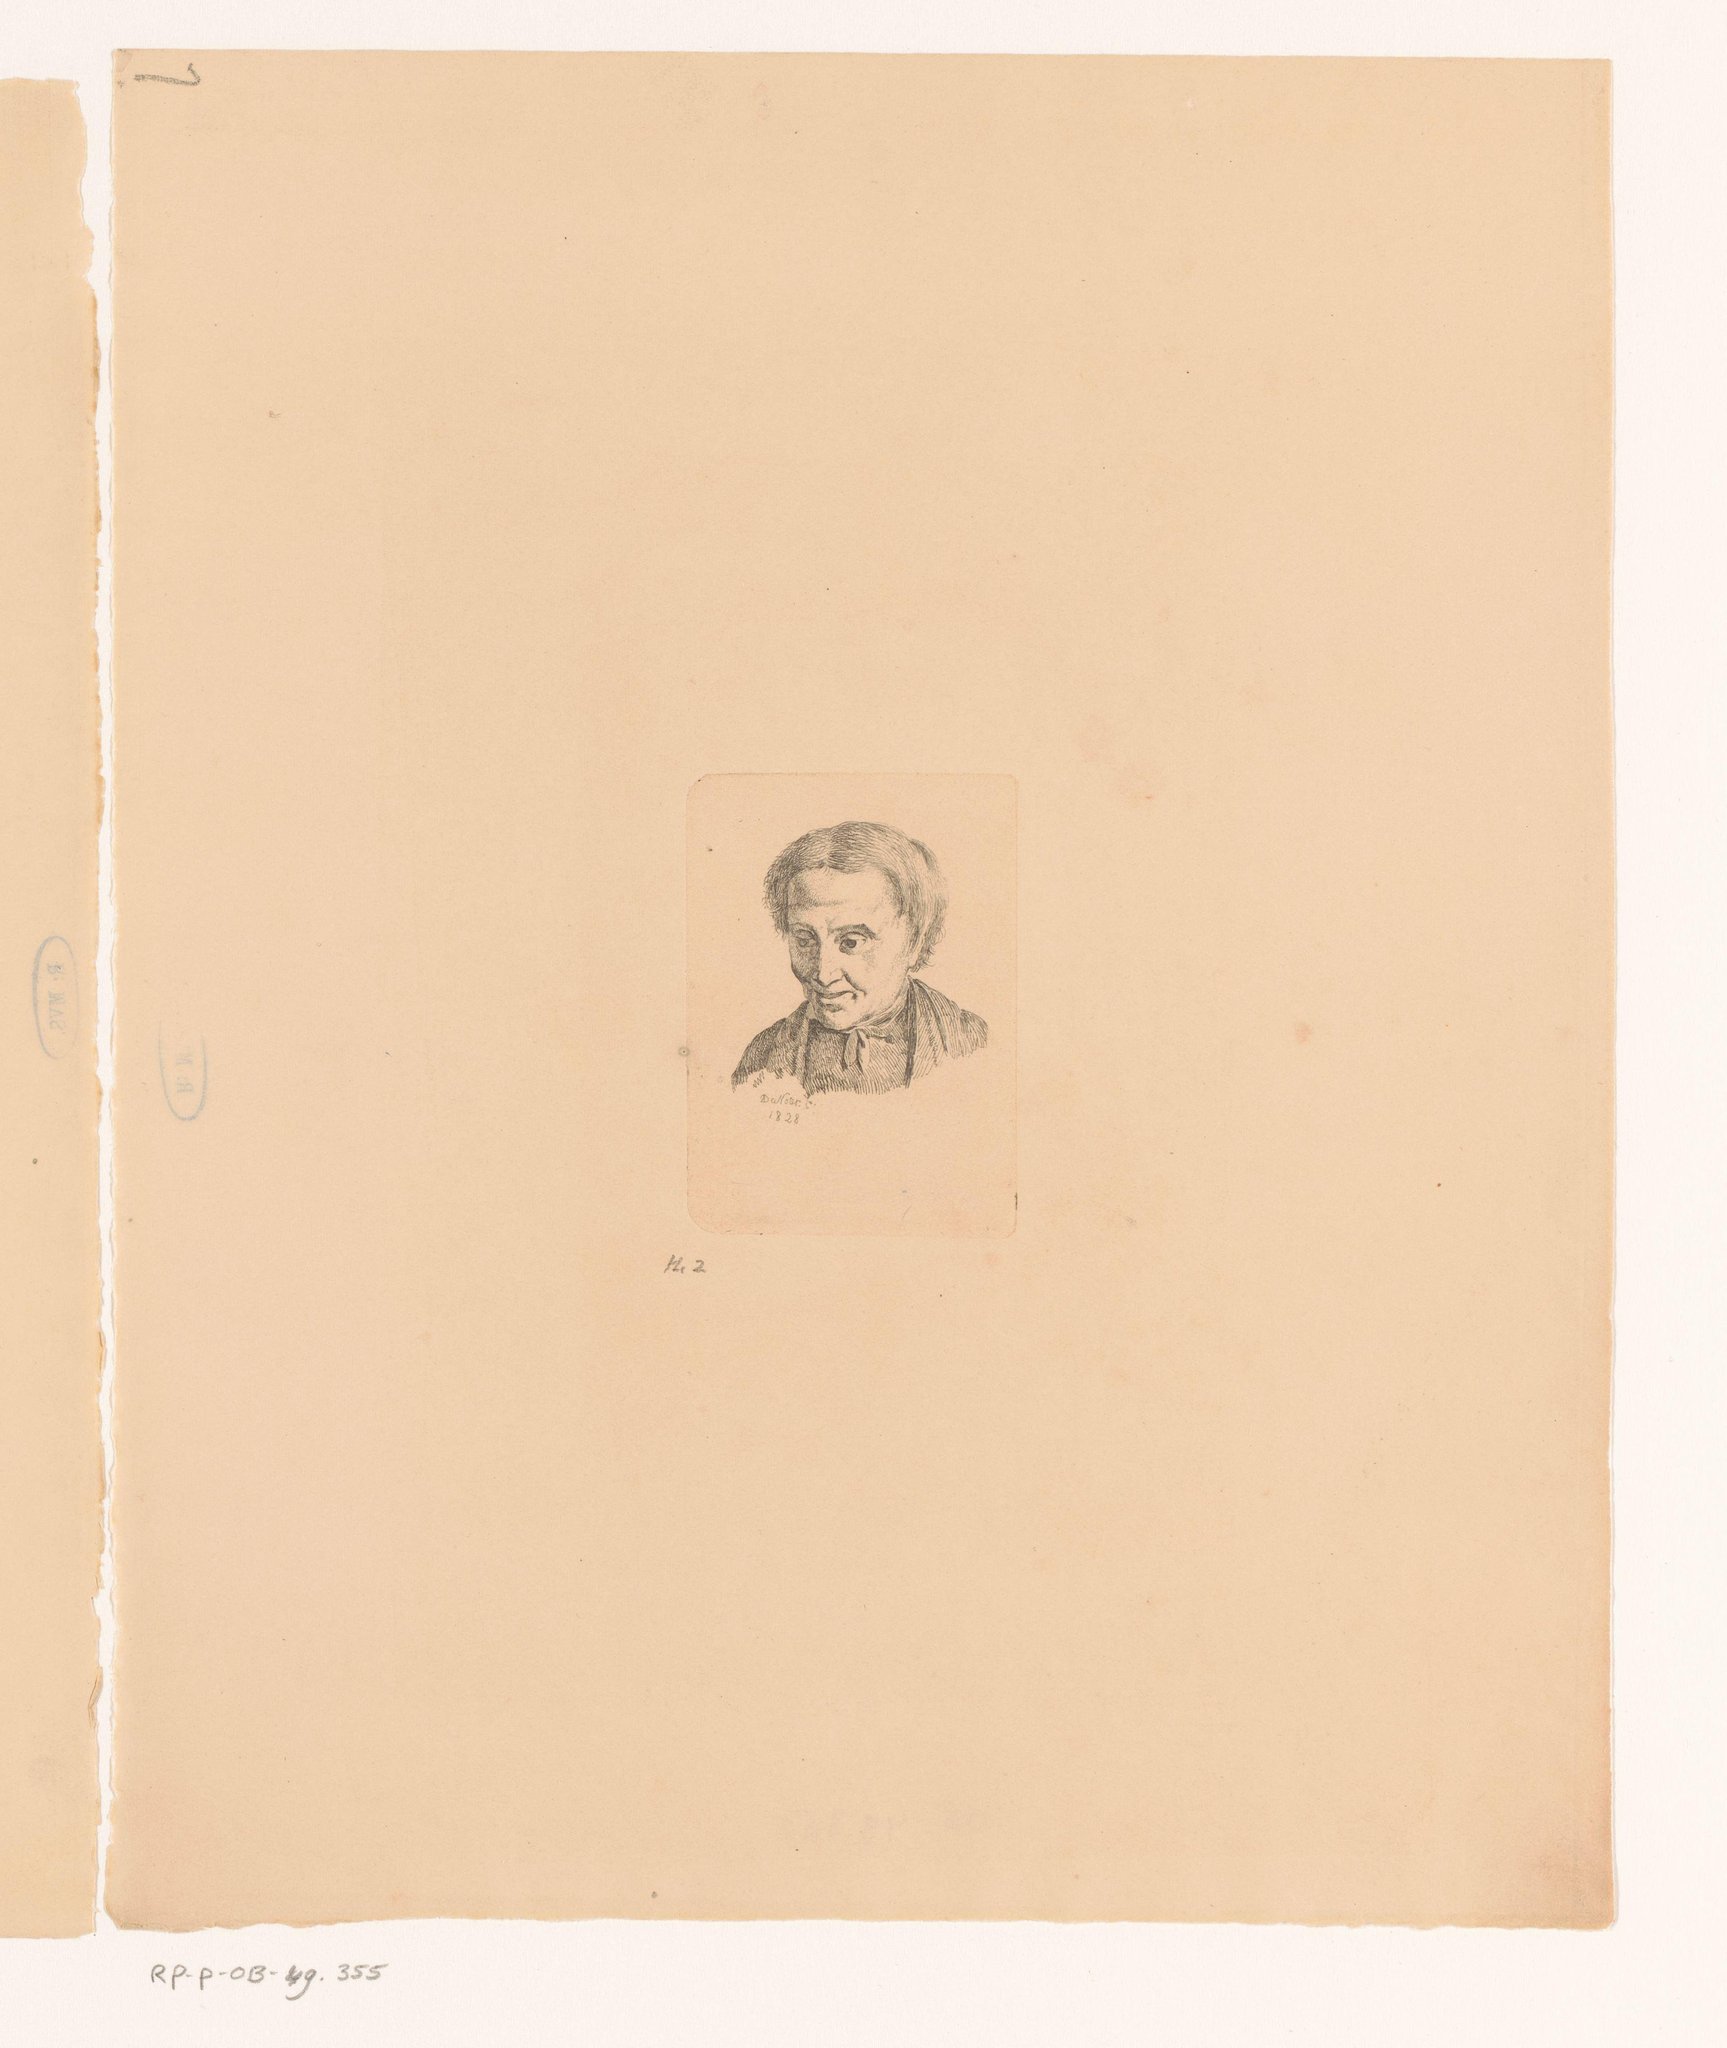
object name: print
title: Hoofd van een oude man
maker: auguste herman marie de noter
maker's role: print maker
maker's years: 1806-1838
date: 1828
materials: paper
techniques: etching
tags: old man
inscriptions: collector's mark: Lugt 2228